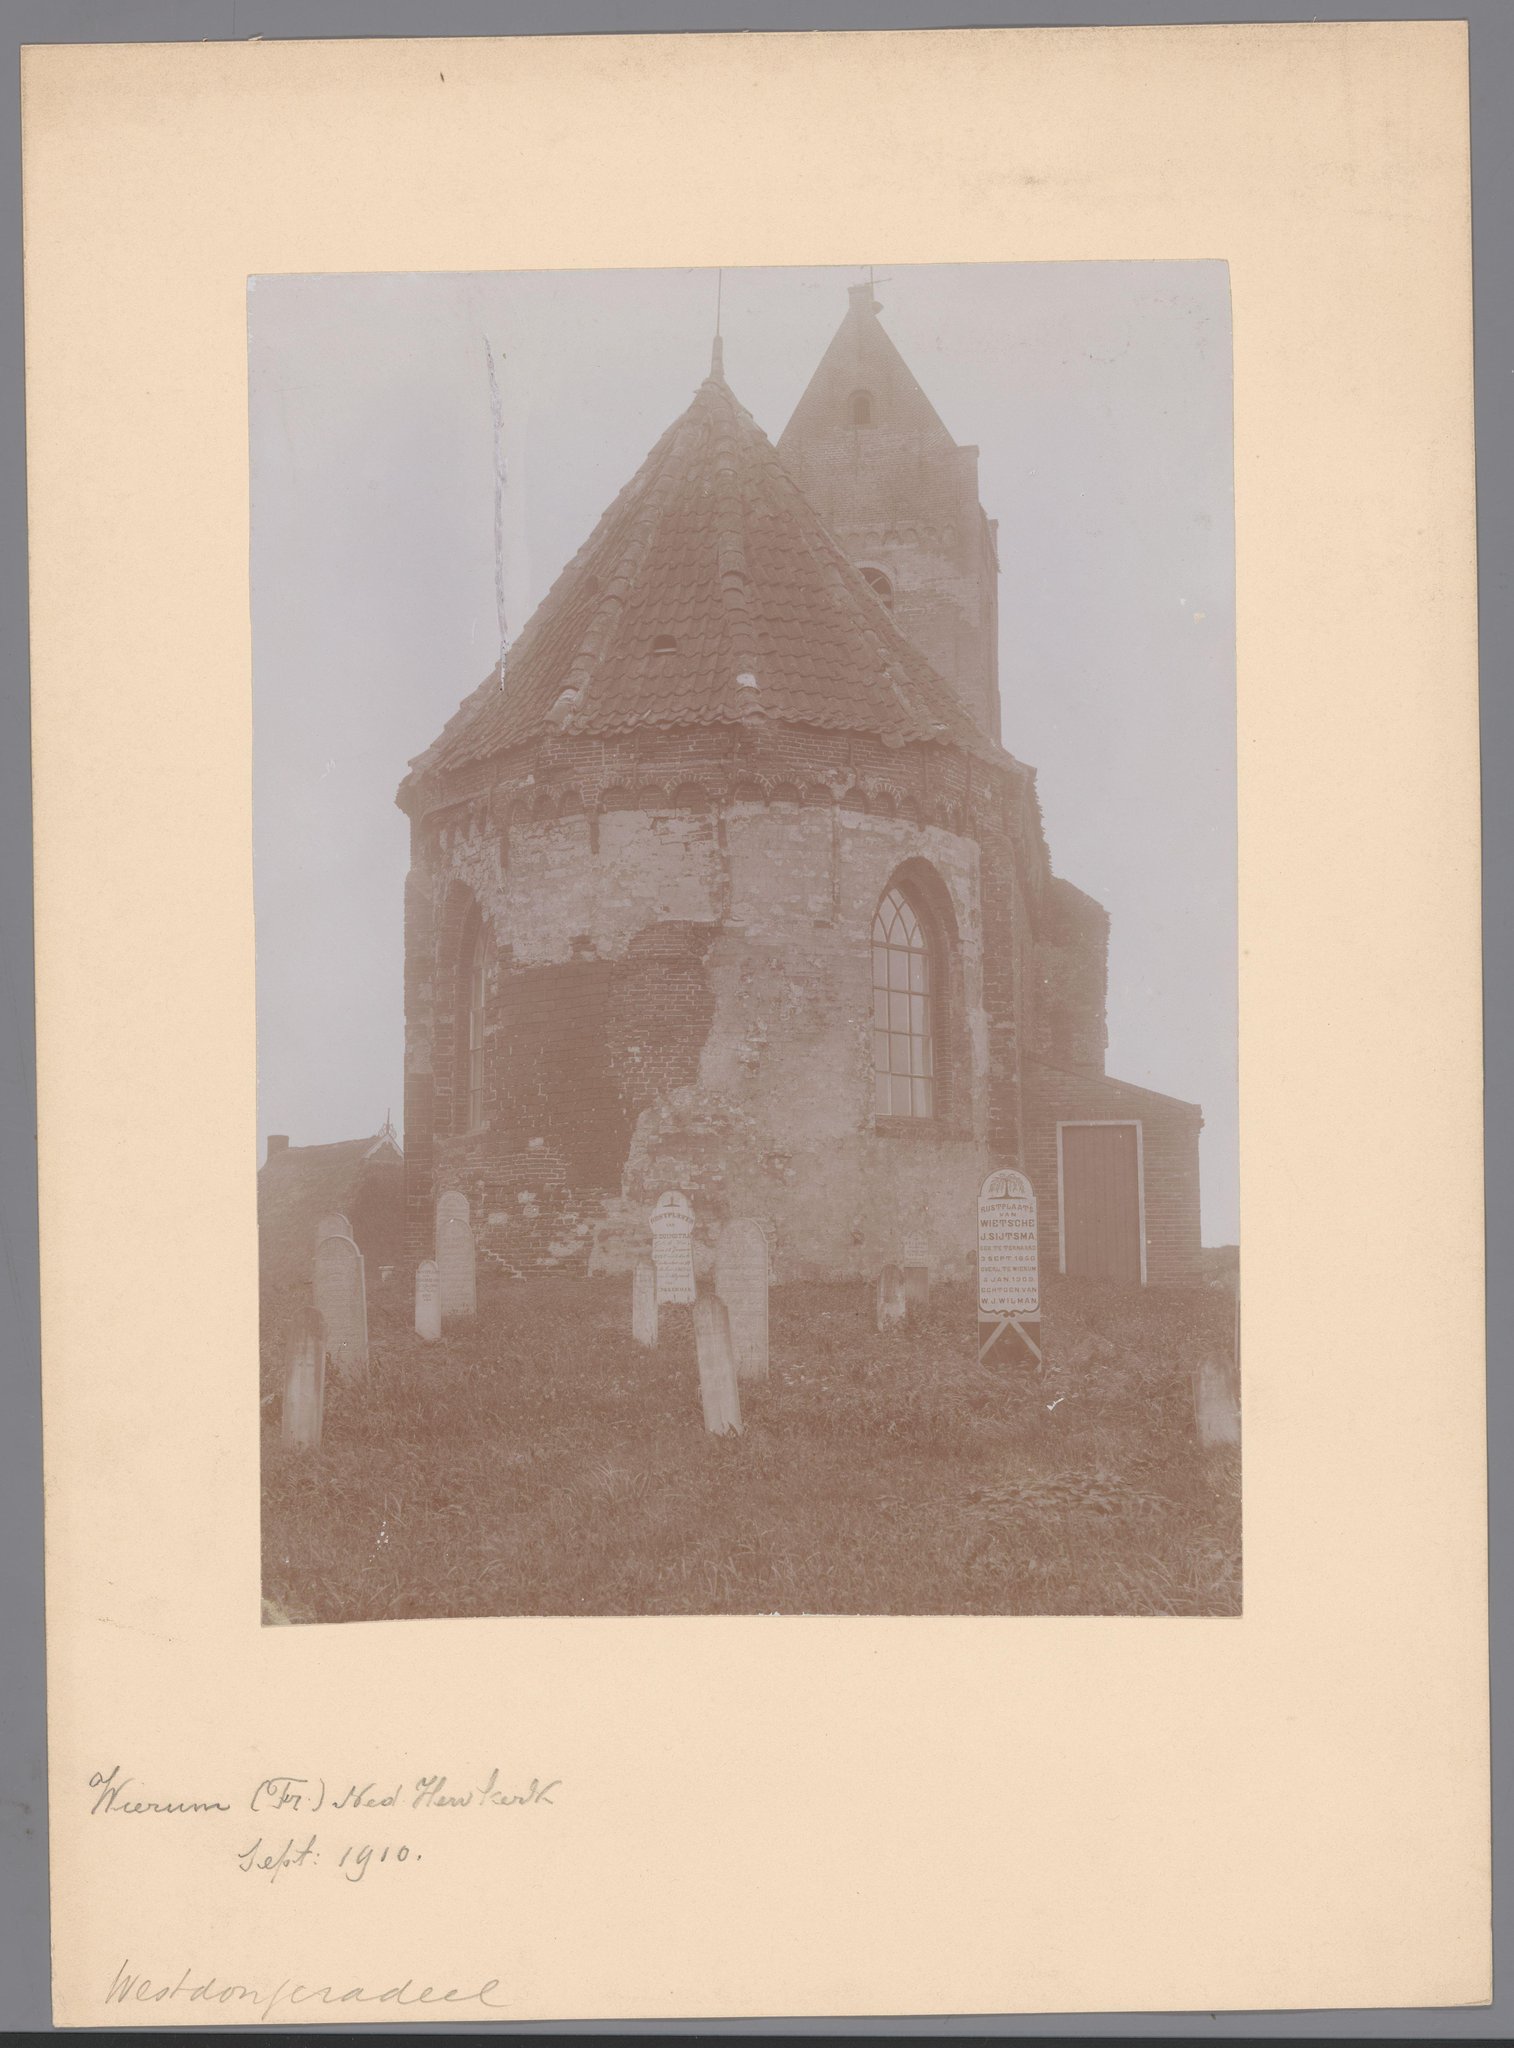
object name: photograph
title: Gezicht op de Hervormde Kerk van Wierum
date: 1910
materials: cardboard, photographic support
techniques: collodion silver print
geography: wierum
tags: church (exterior), churchyard, cemetery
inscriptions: annotation: ‘Wierum (Fr) Ned. Herv. kerk / Sept: 1910/ Westdongeradeel’